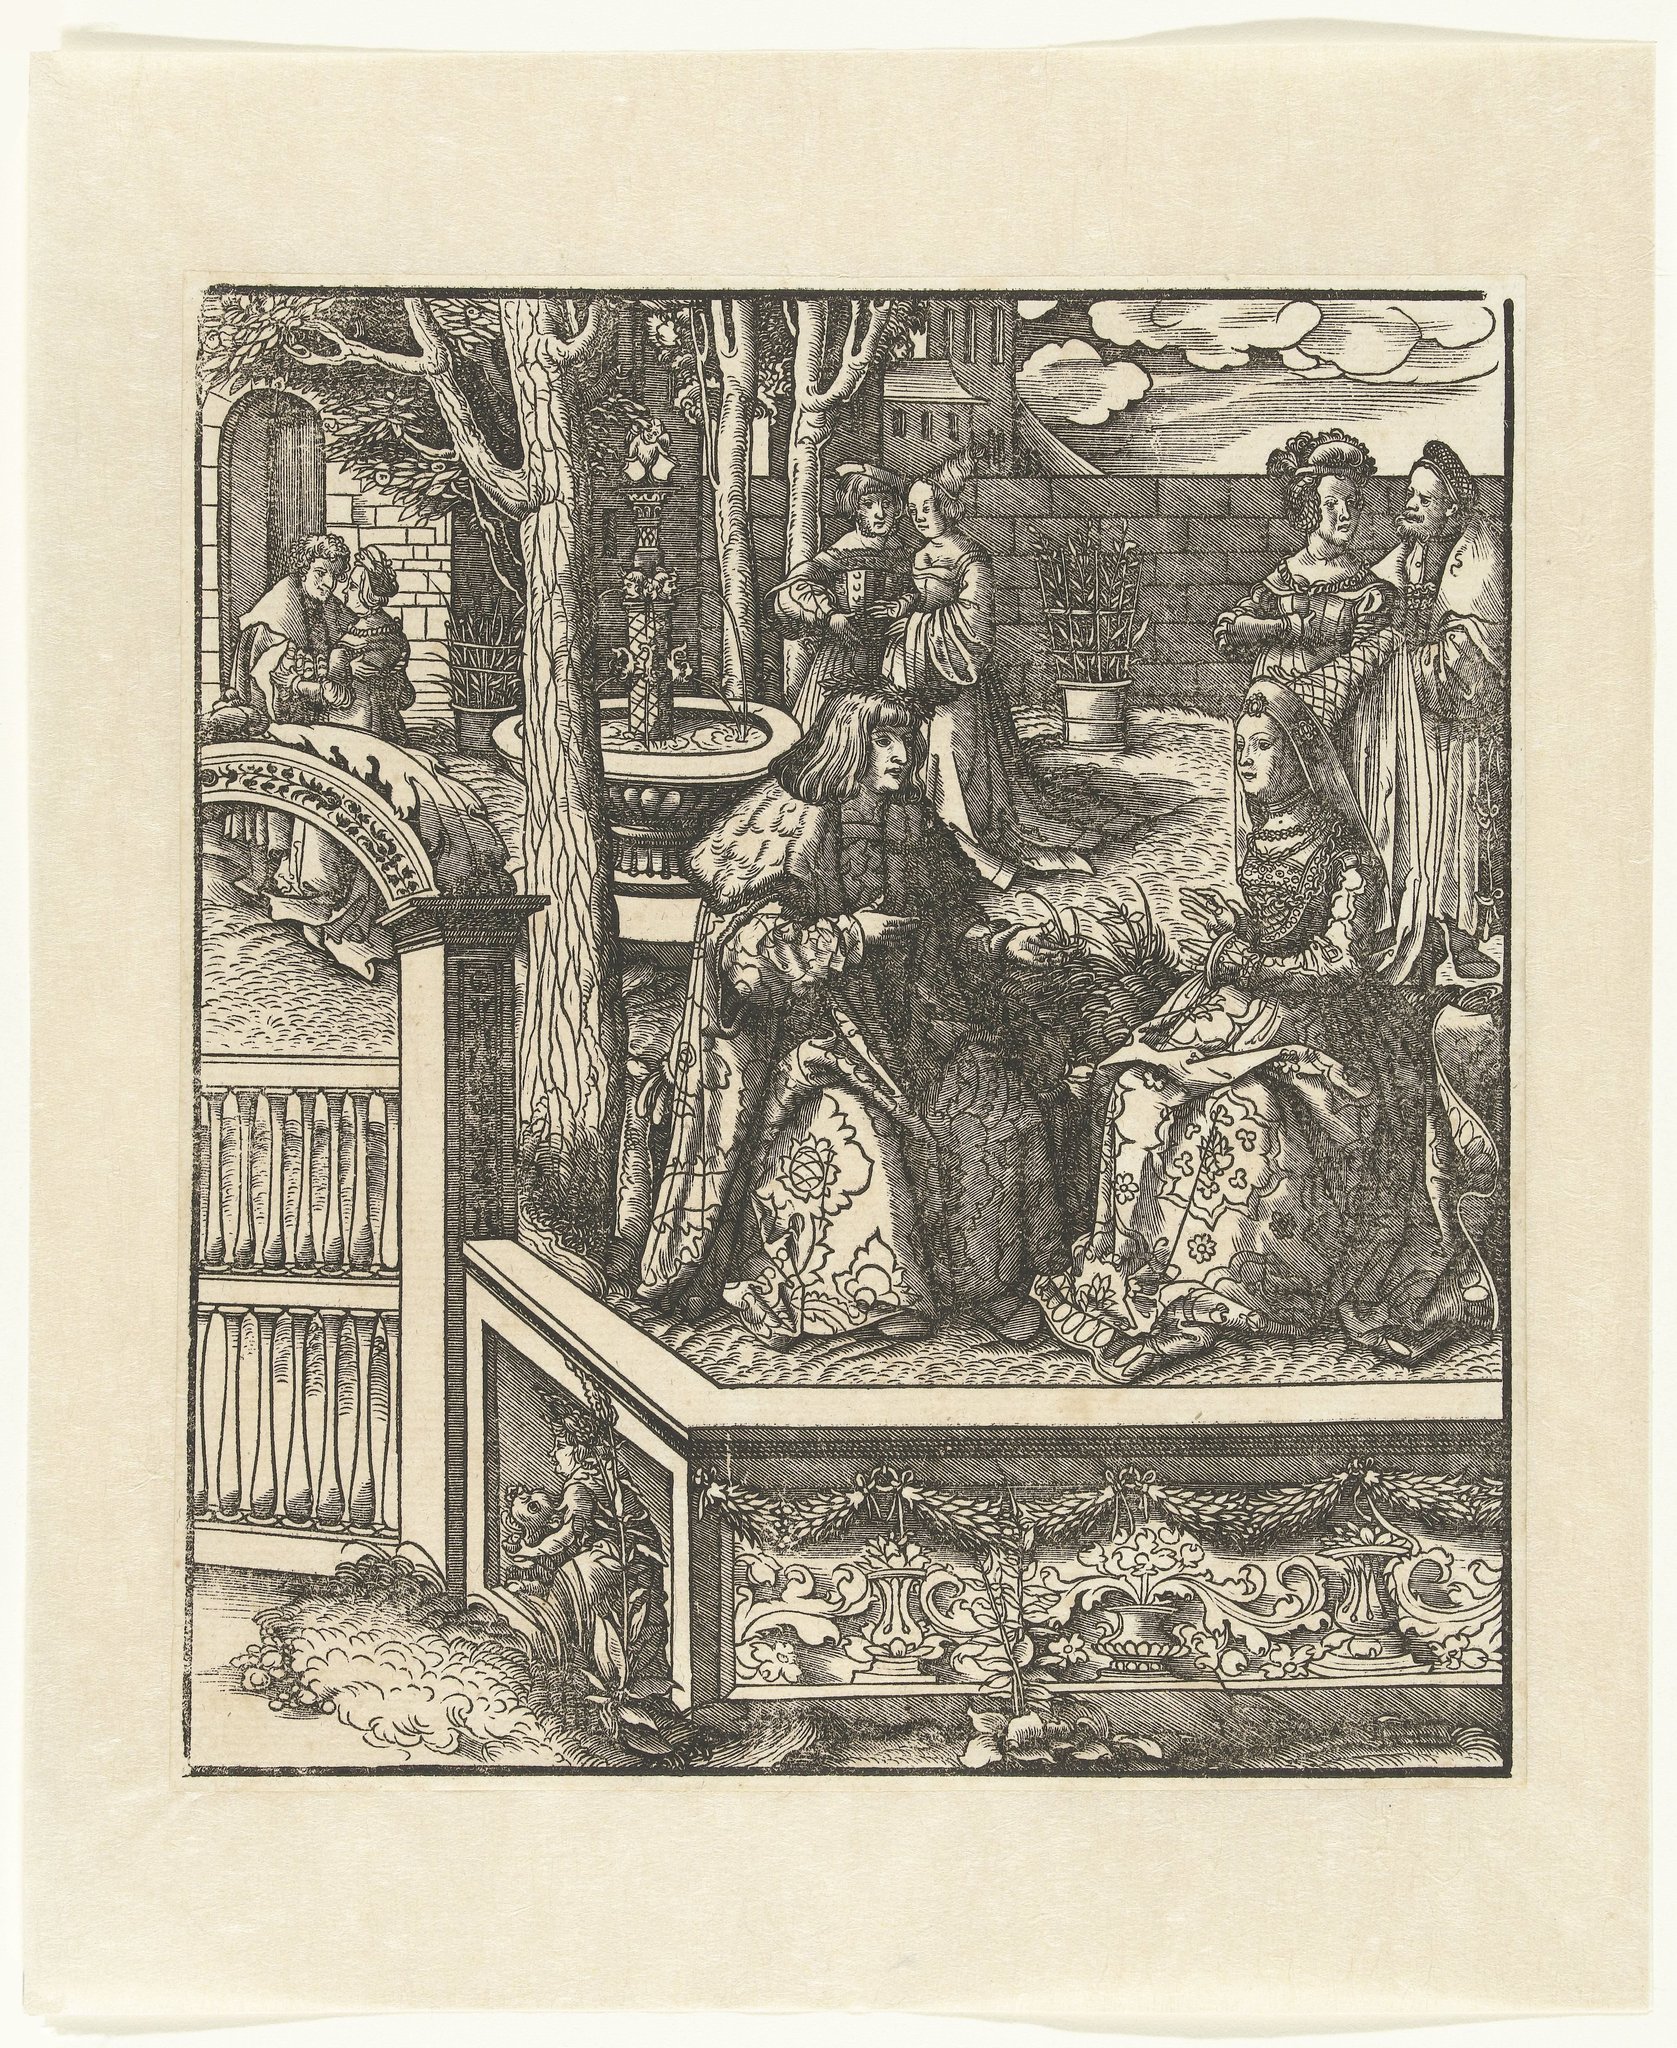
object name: print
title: Maximiliaan en Maria van Bourgondië leren elkaar hun taal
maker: leonhard beck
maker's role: draughtsman, painter, print maker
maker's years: 1475-1542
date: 1512-1516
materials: paper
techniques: woodcut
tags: brussels, maria (hertogin van bourgondië), maximilian i (holy roman emperor)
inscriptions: collector's mark: Lugt 2228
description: Houtblok gebruikt voor: Marx Treitzsaurwein, Der Weißkunig, 1512-1516. Vergelijk houtsnede van Burgkmair welke werd verworpen voor de uitgave, Leonhard Beck werd duidelijk geïnspireerd door zijn compositie (afbeelding bij Biedermann 1973, cat. nr. 189 en 190).